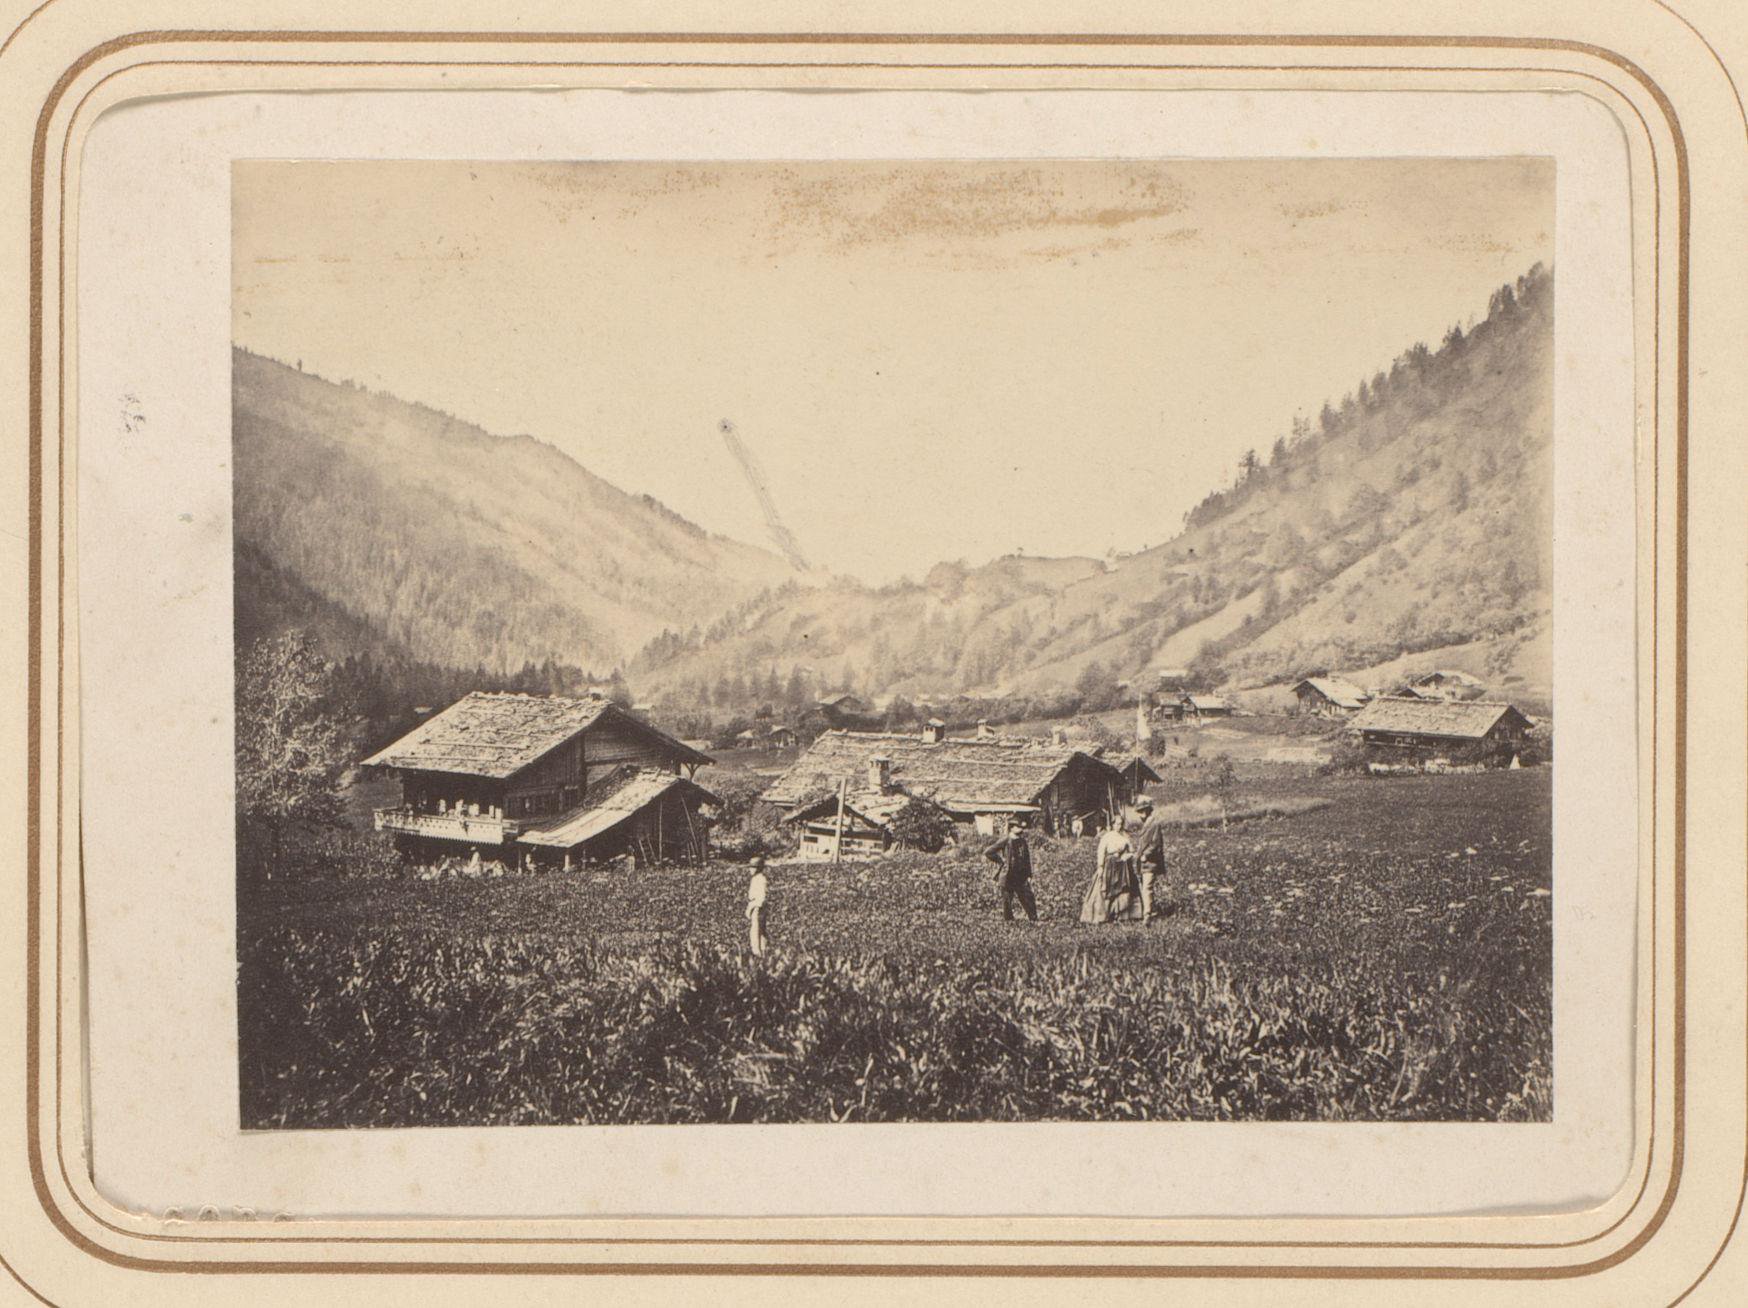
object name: album leaf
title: Berglandschap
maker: Anonymous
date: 1870-1875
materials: cardboard, photographic support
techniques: albumen print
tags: landscapes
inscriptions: inscription: ‘[...]’